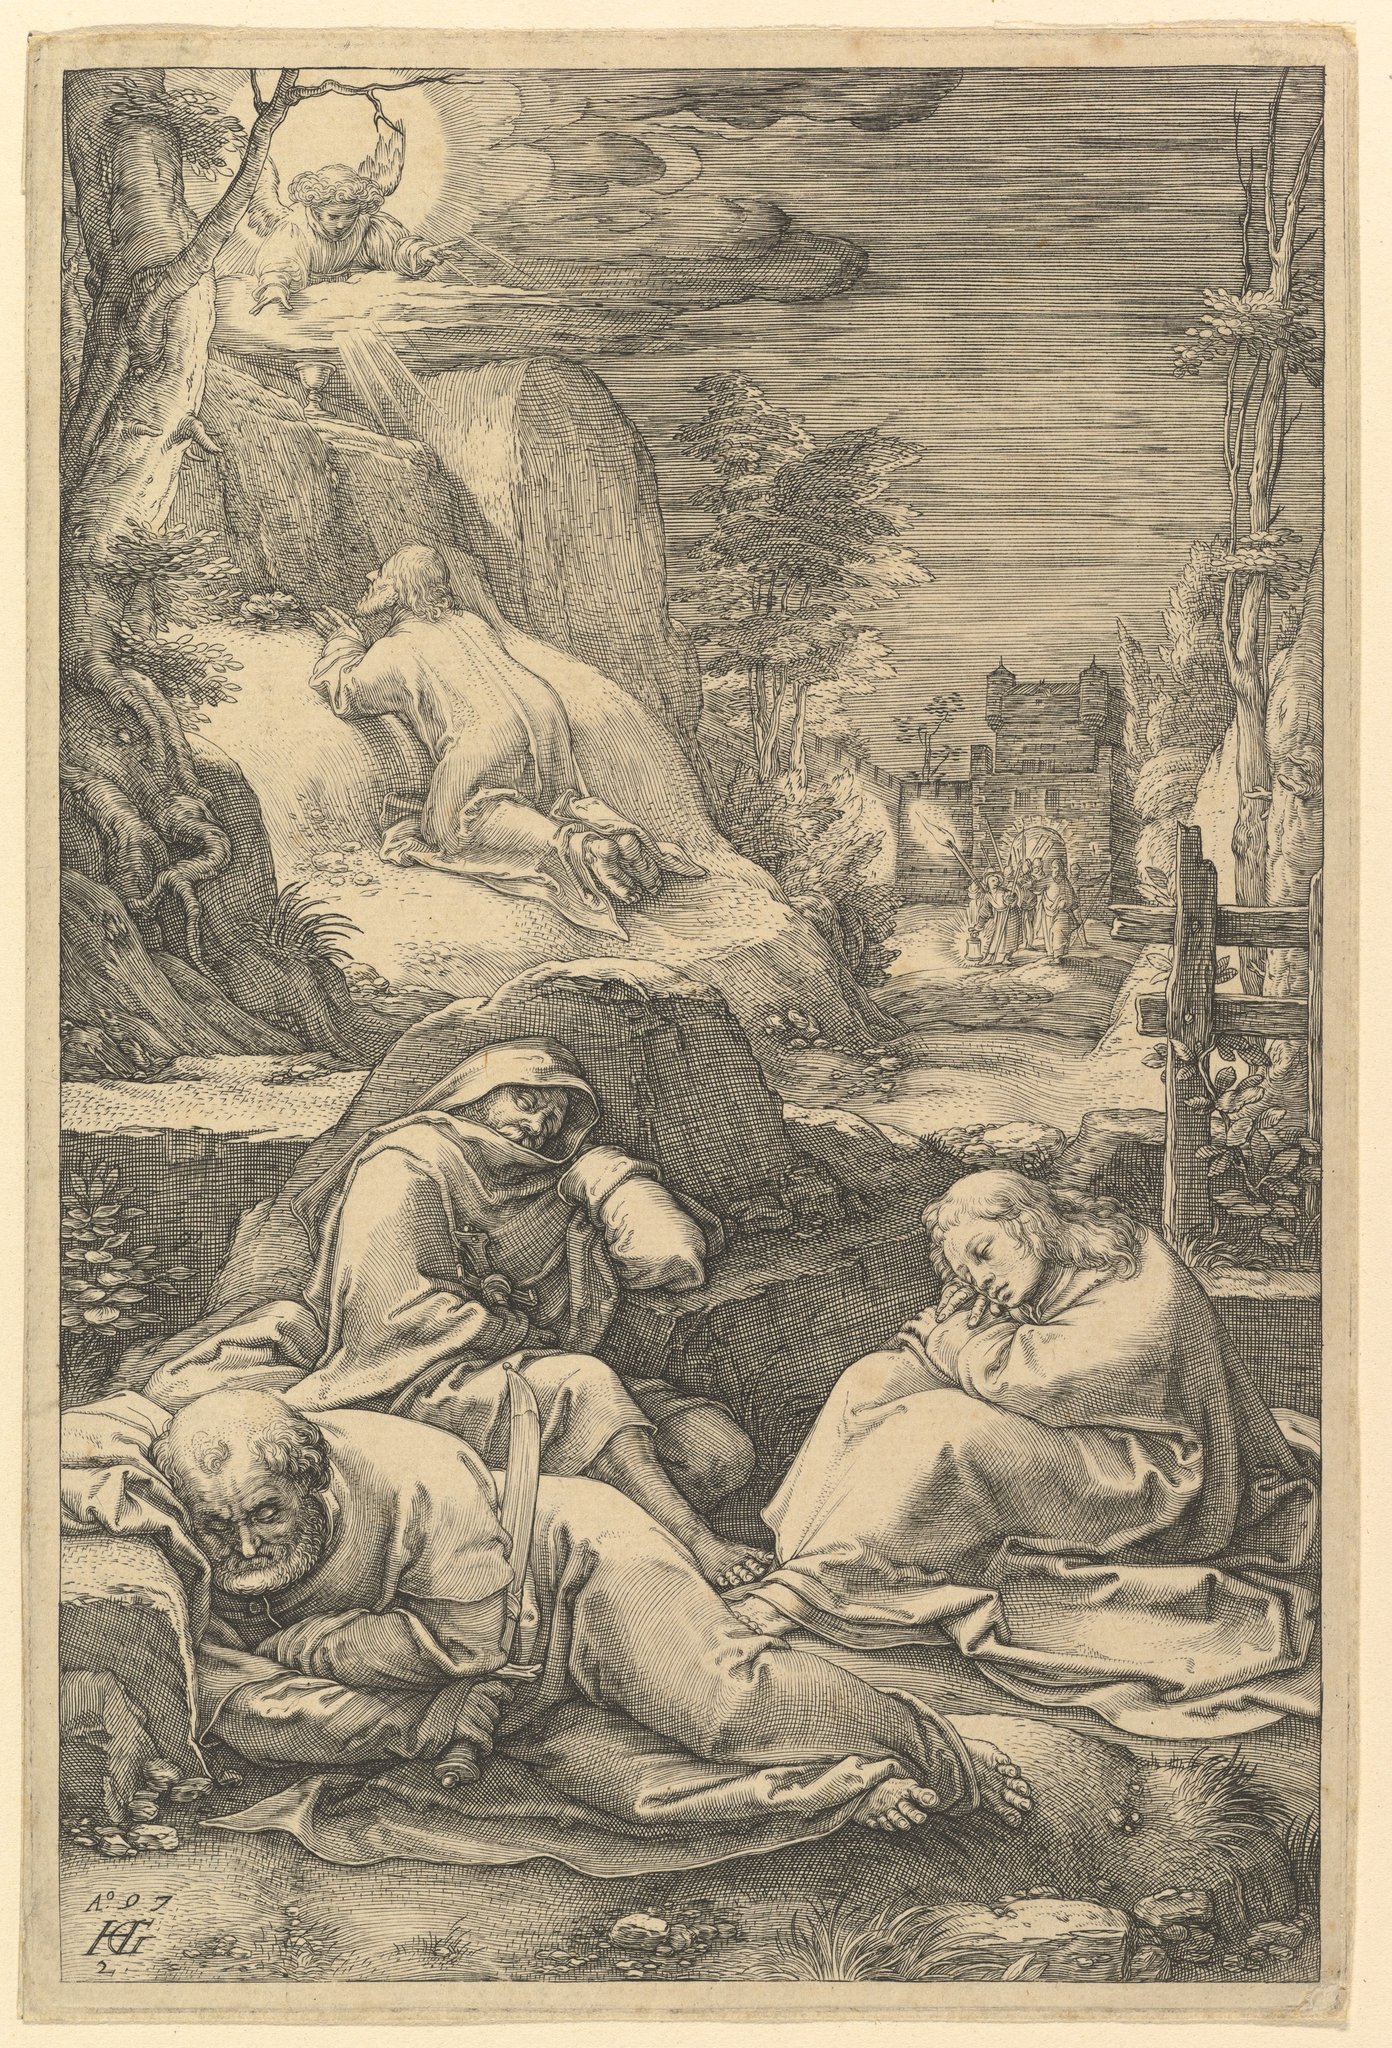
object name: print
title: The Agony in the Garden, from "The Passion of Christ"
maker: hendrick goltzius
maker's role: artist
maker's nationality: netherlandish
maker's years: 1558-1617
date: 1597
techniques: engraving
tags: sadness,men,angels,apostles,jesus